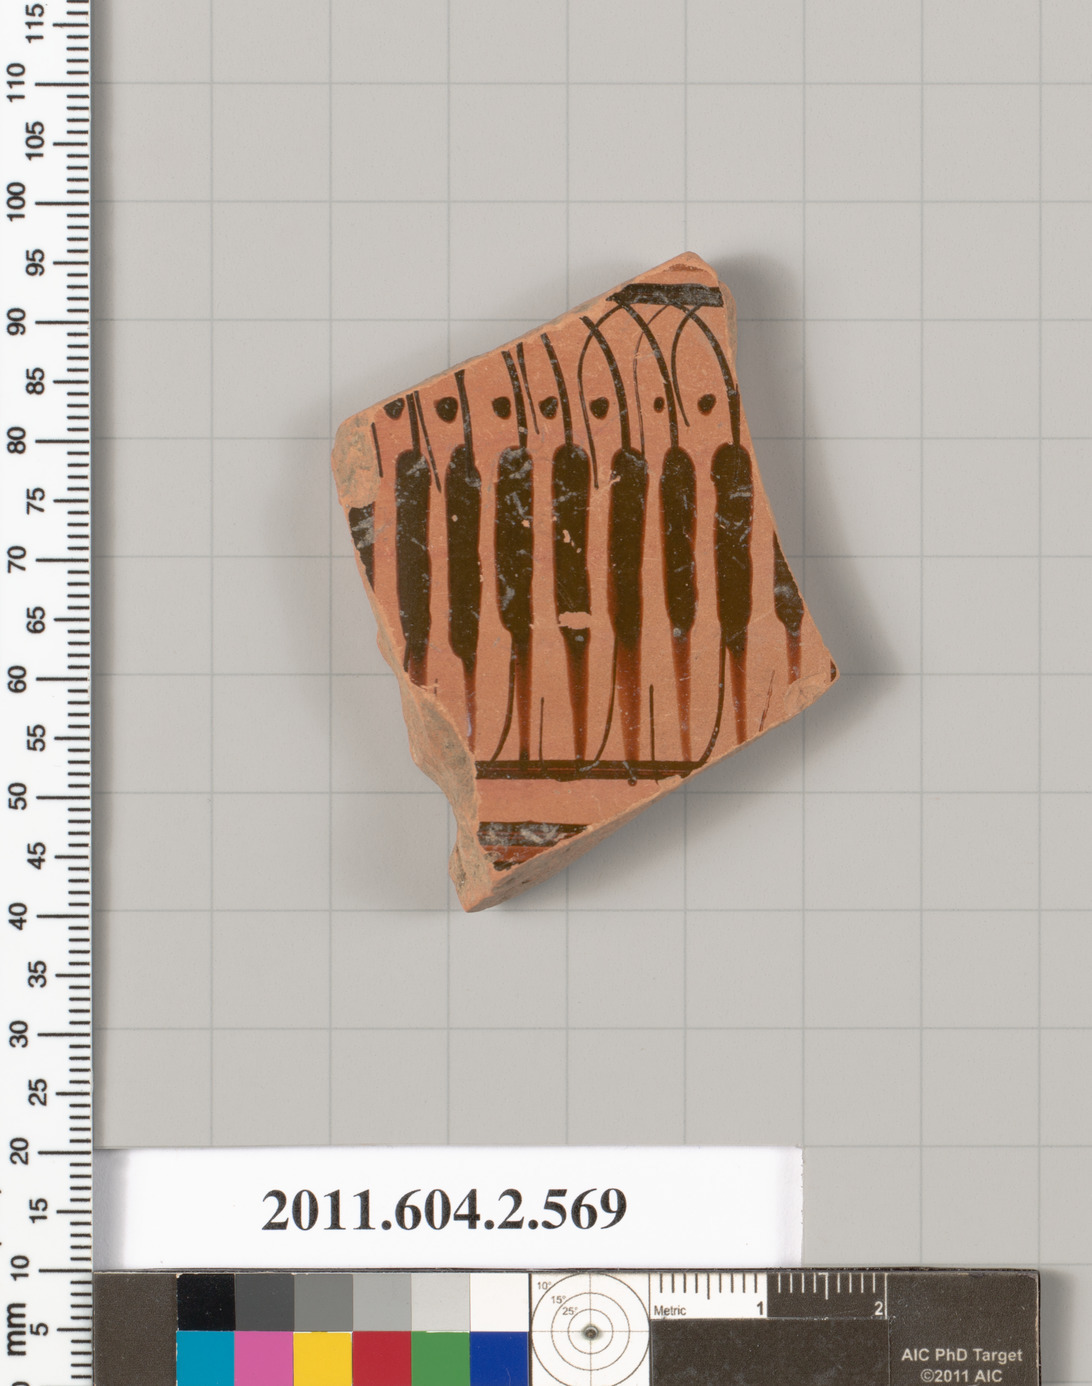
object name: column krater fragment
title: Terracotta fragment of a column-krater (bowl for mixing wine and water)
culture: greek, attic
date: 460-440 BCE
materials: terracotta